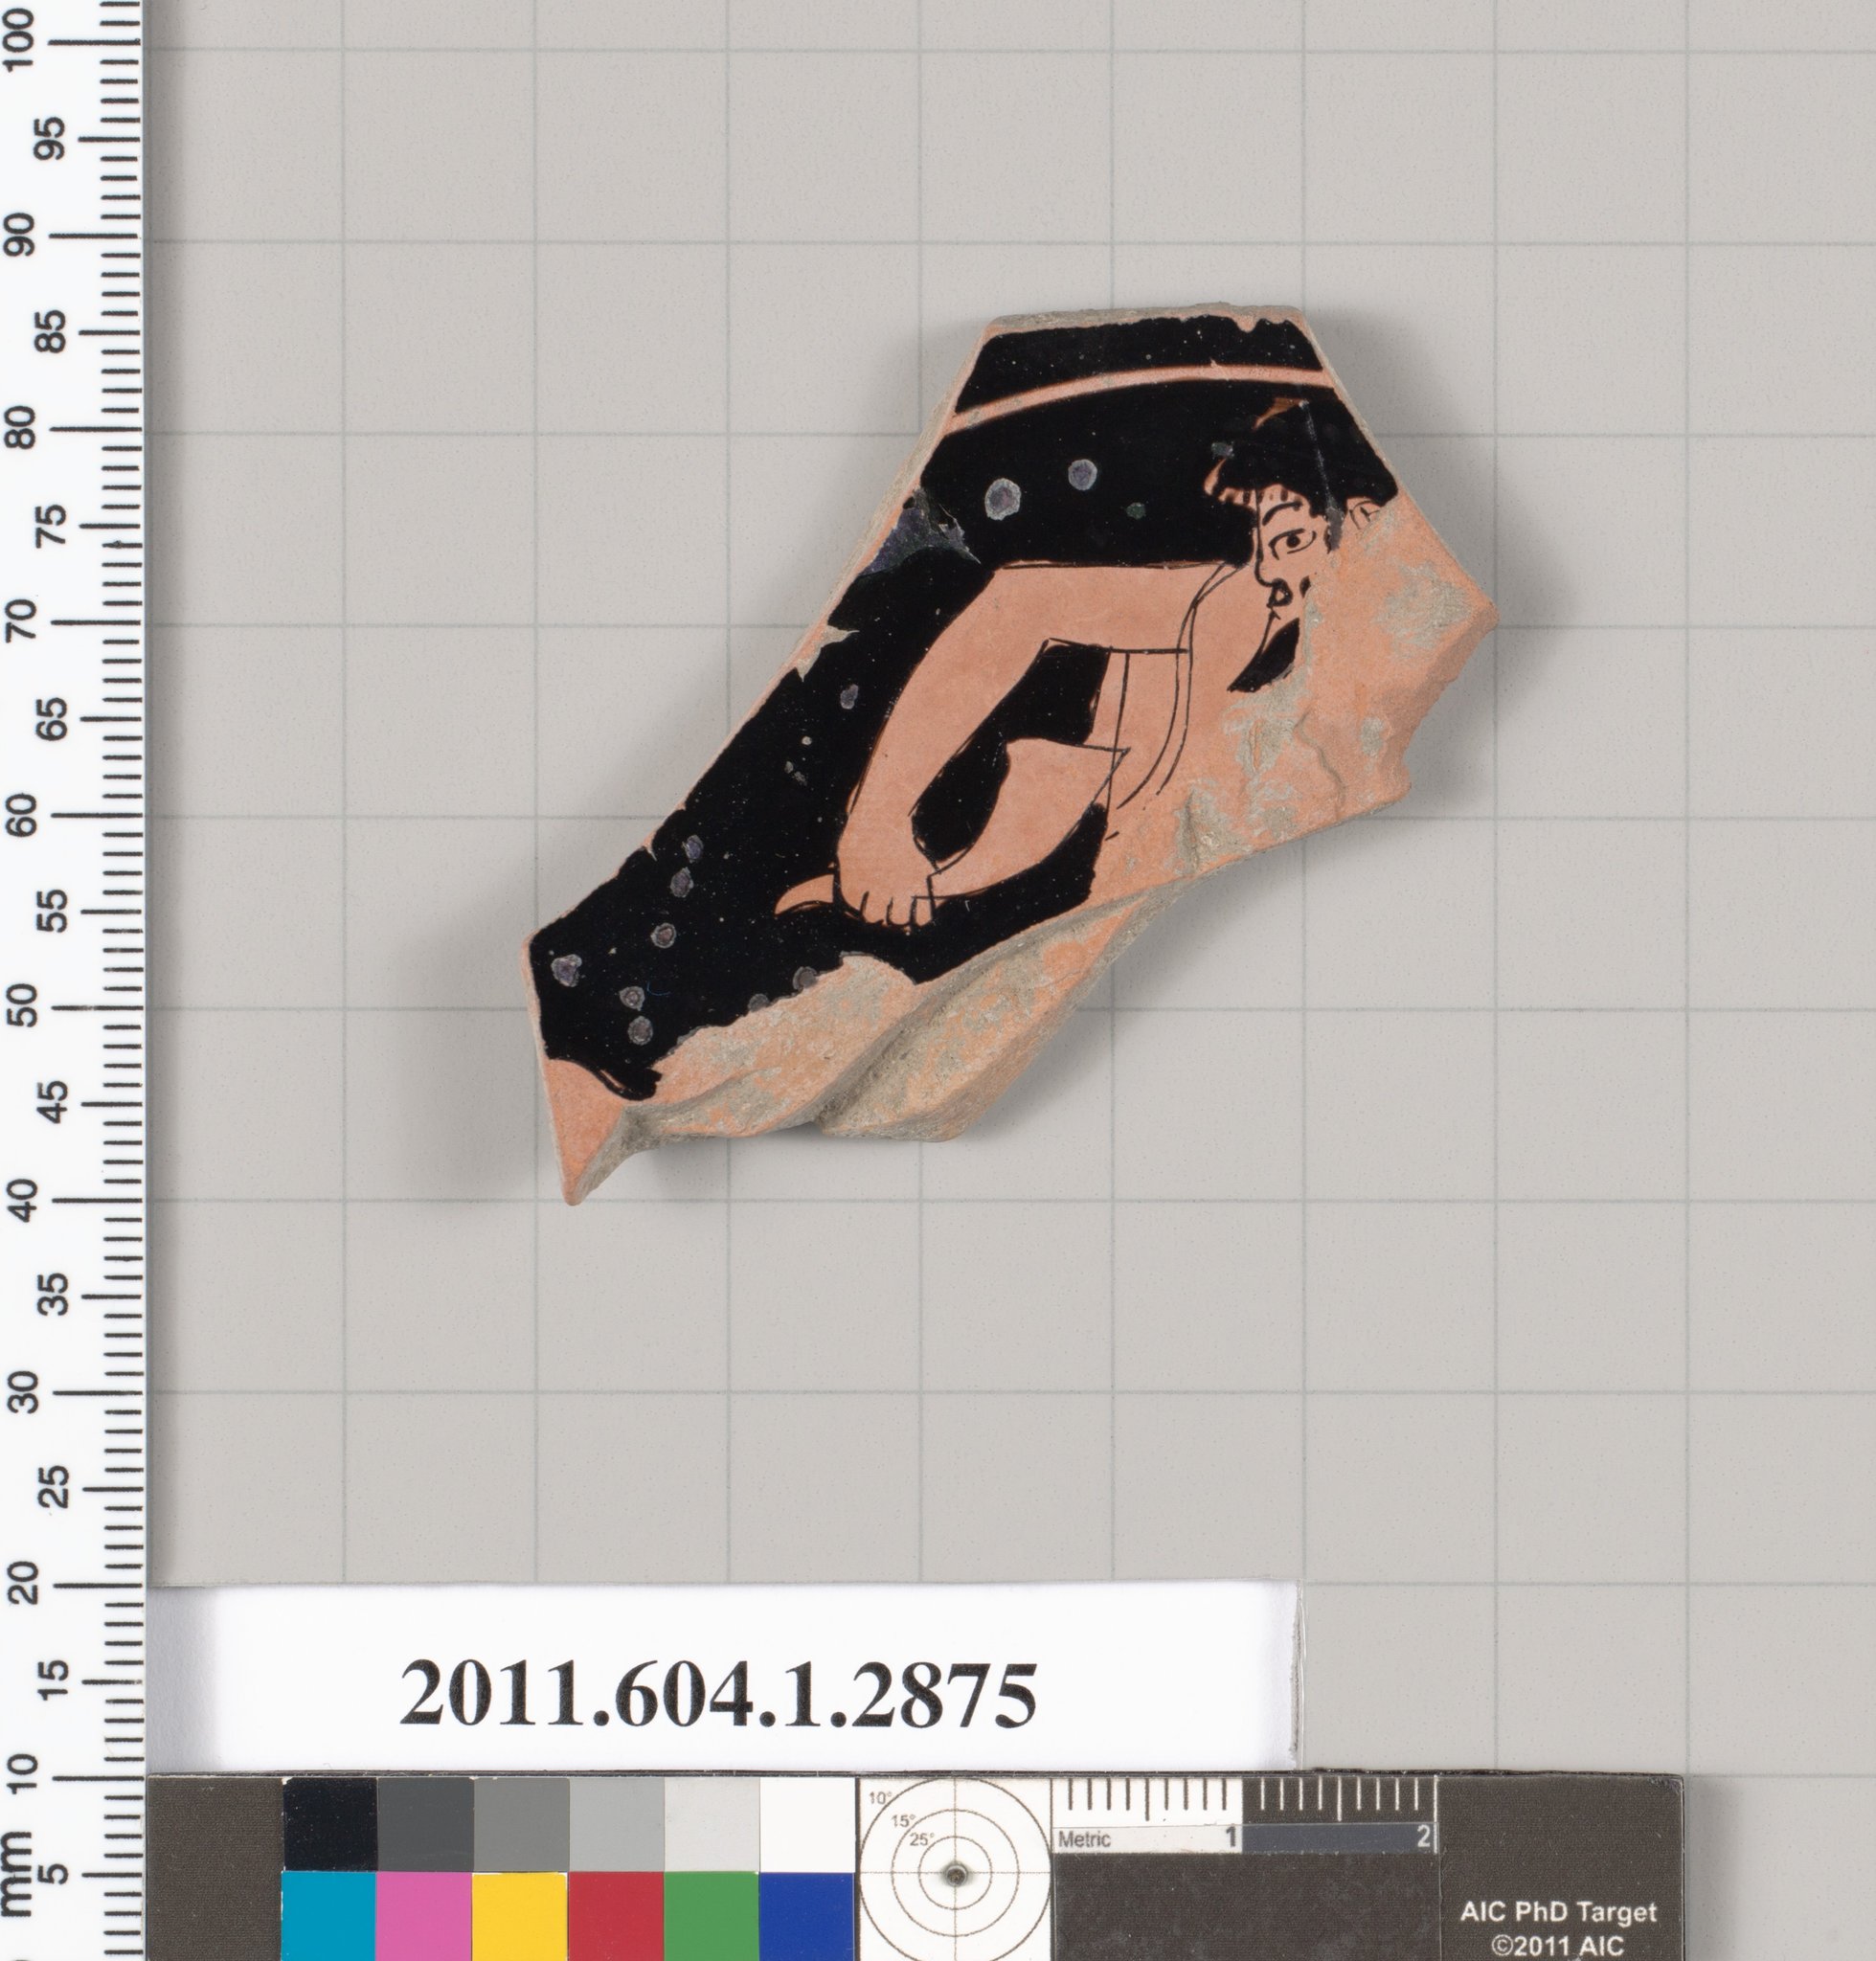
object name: kylix fragment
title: Terracotta fragment of a kylix (drinking cup)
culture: greek, attic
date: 520-500 BCE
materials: terracotta